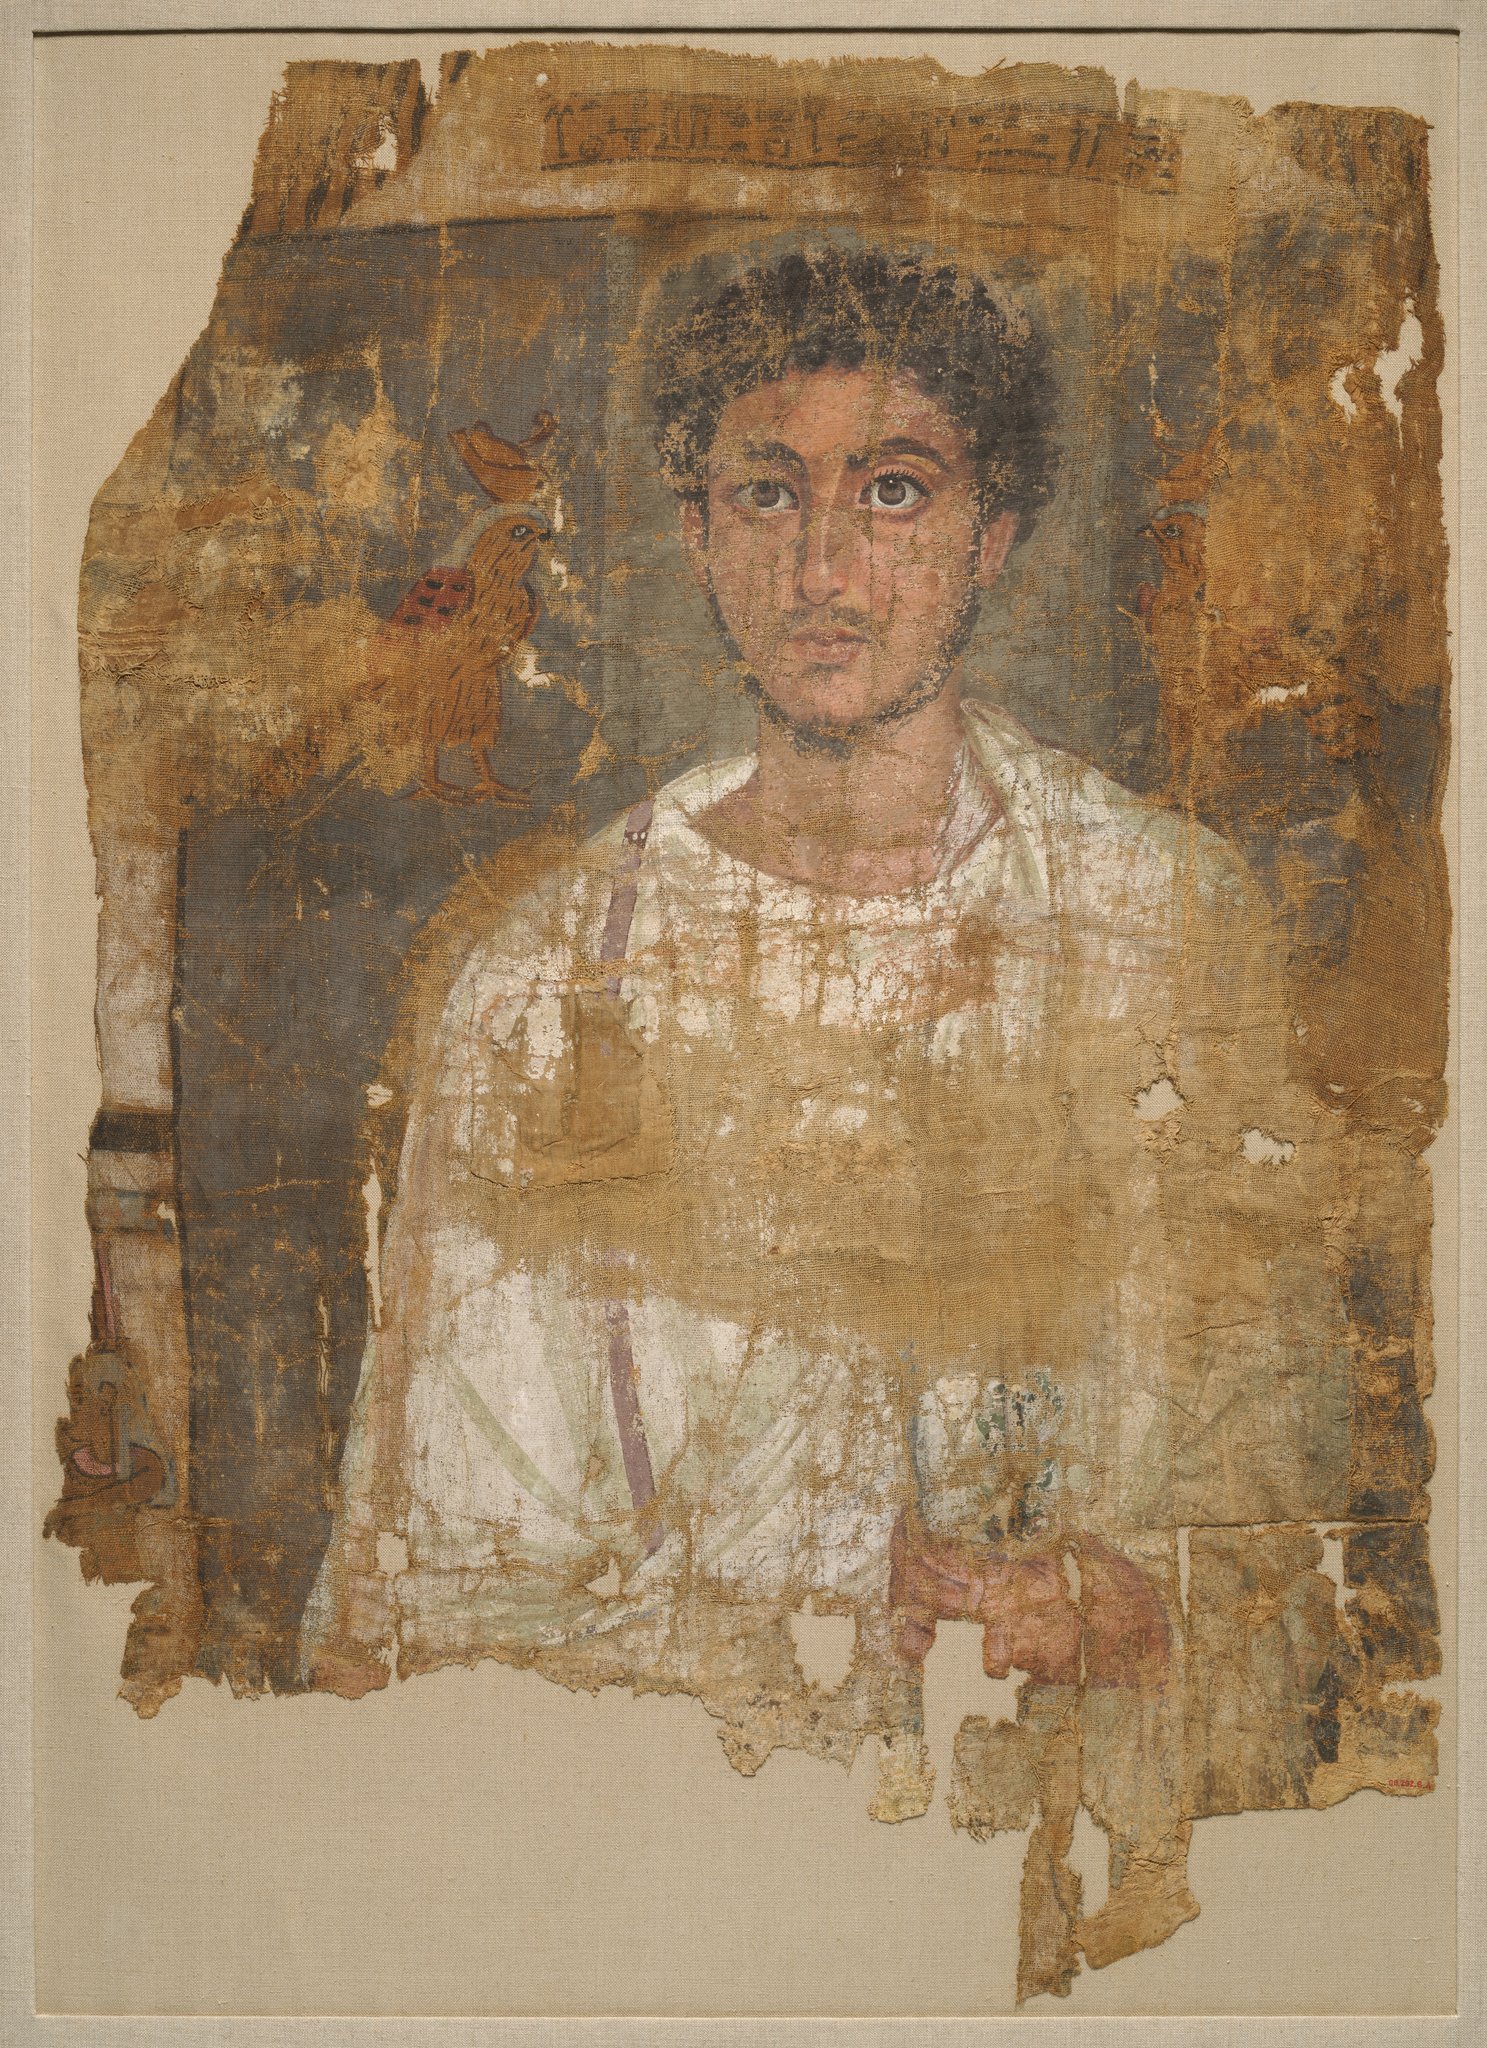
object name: shroud fragment, bearded man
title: Fragmentary Shroud with a Bearded Young Man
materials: linen, paint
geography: egypt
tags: men,portraits,hieroglyphs,horus